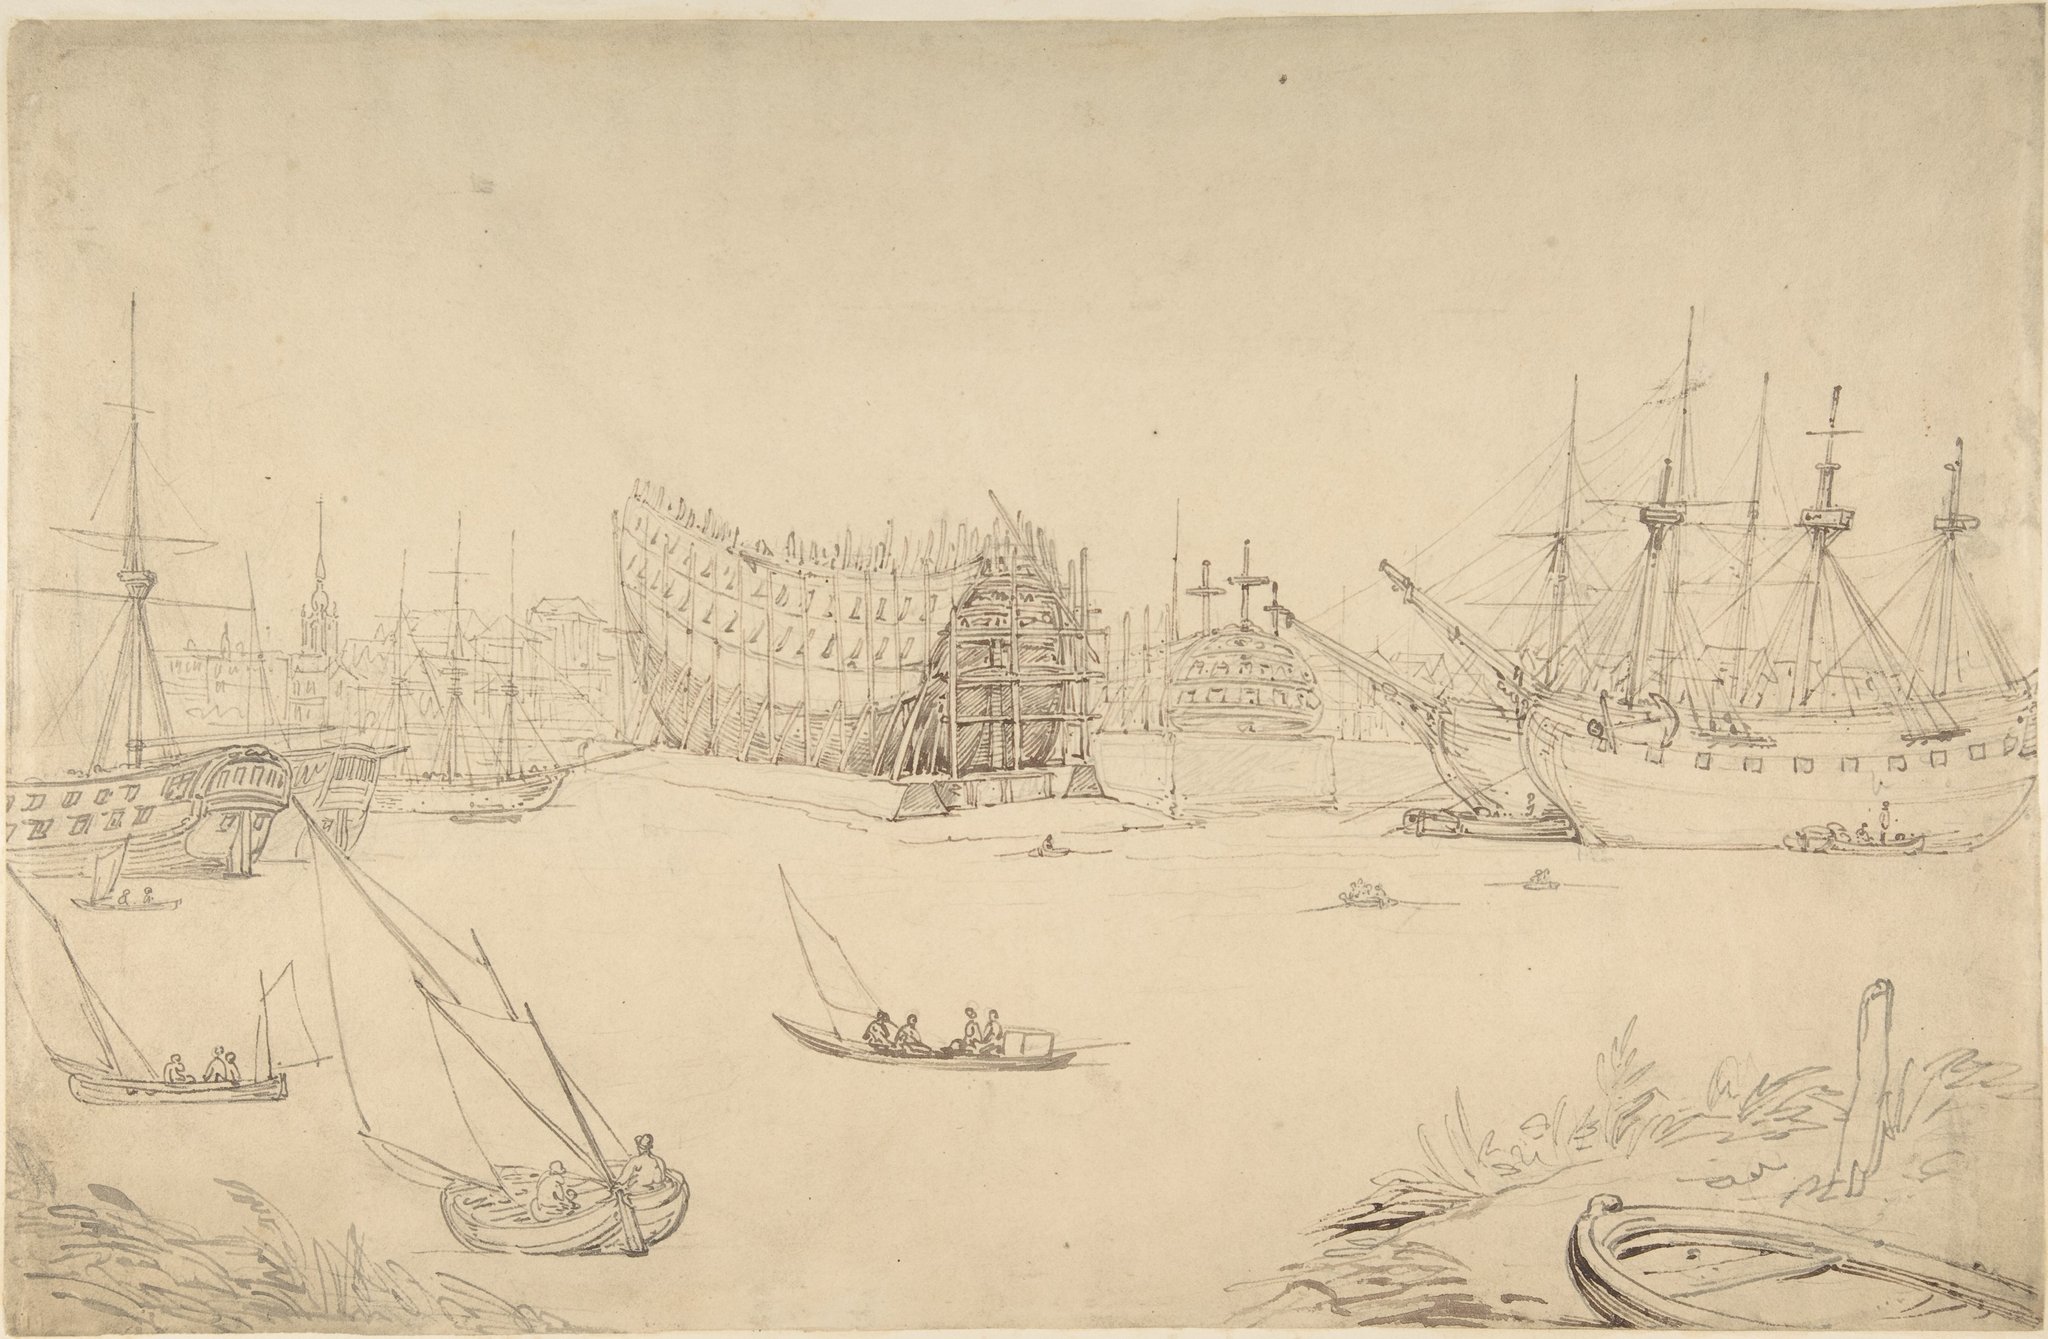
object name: drawing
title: Harbor scene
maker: thomas rowlandson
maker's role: artist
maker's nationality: british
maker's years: 1757-1827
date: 1775-1827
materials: ink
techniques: pen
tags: boats,ships,harbors